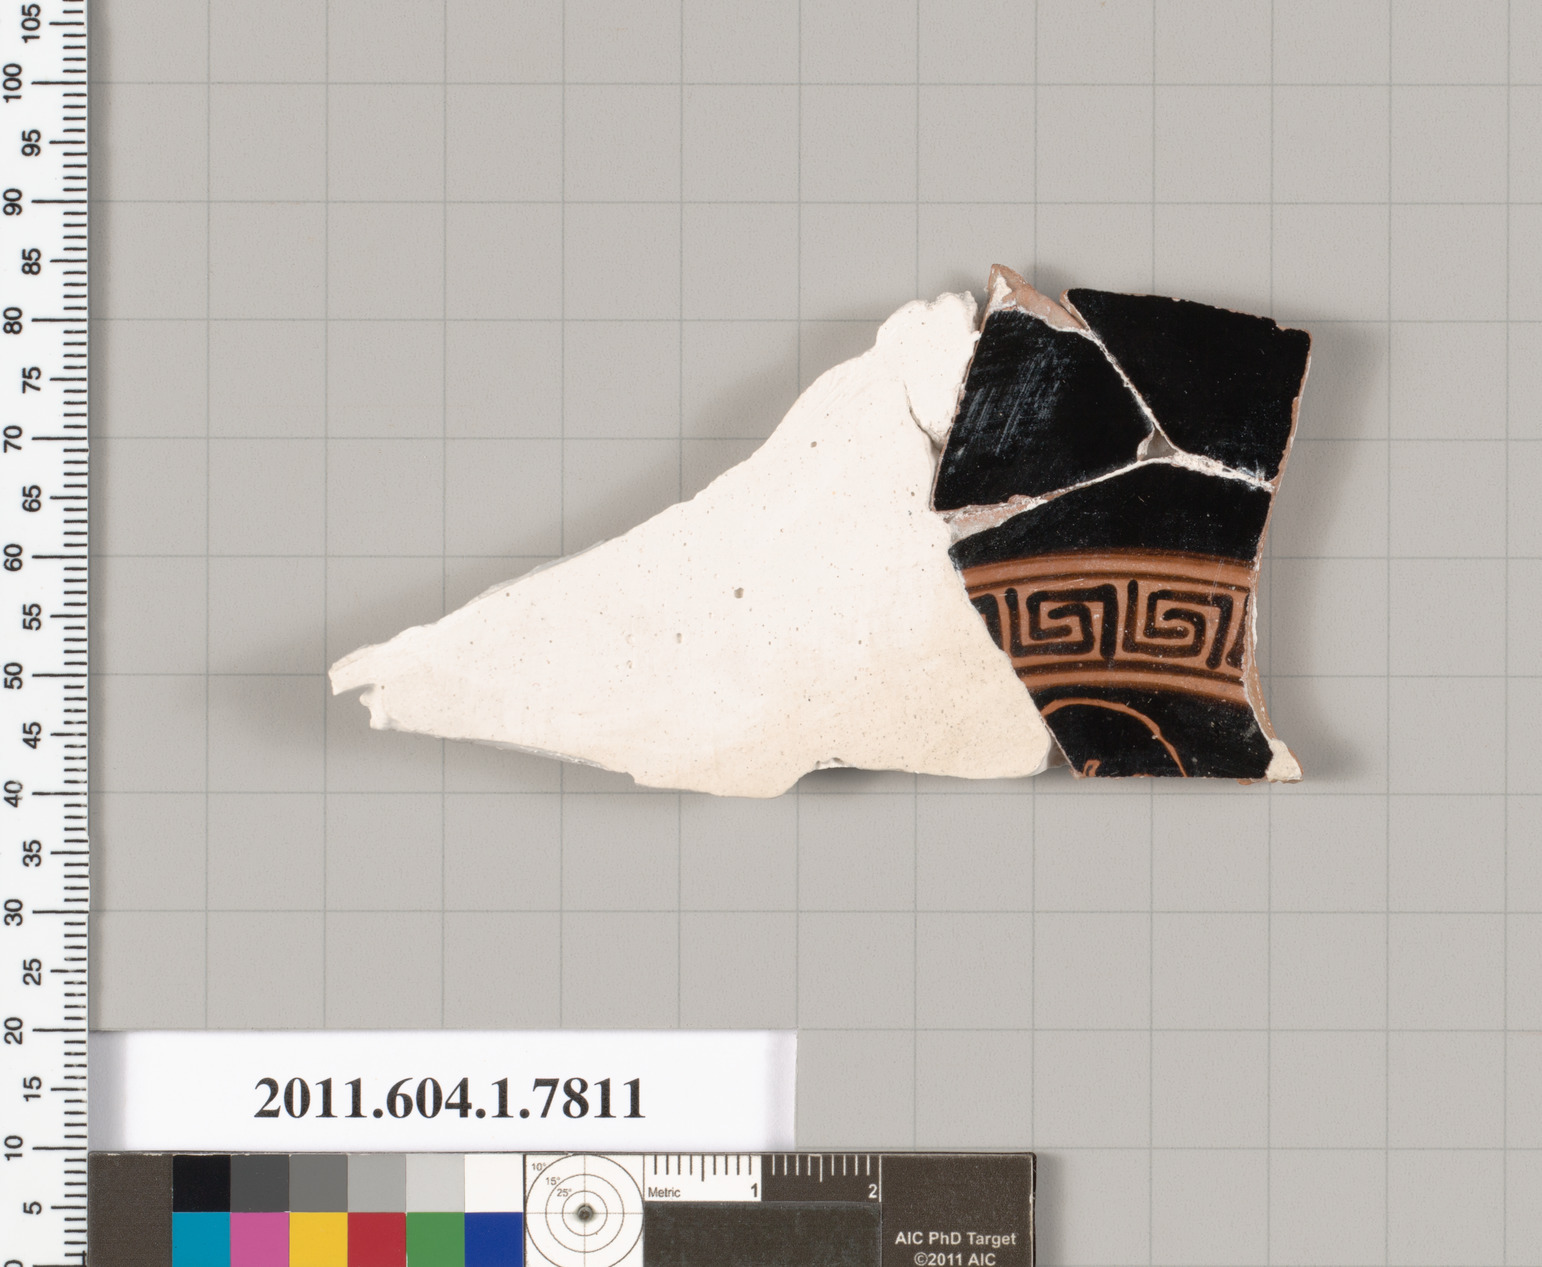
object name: kylix fragment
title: Terracotta fragment of a kylix (drinking cup)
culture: greek, attic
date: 460-450 BCE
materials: terracotta